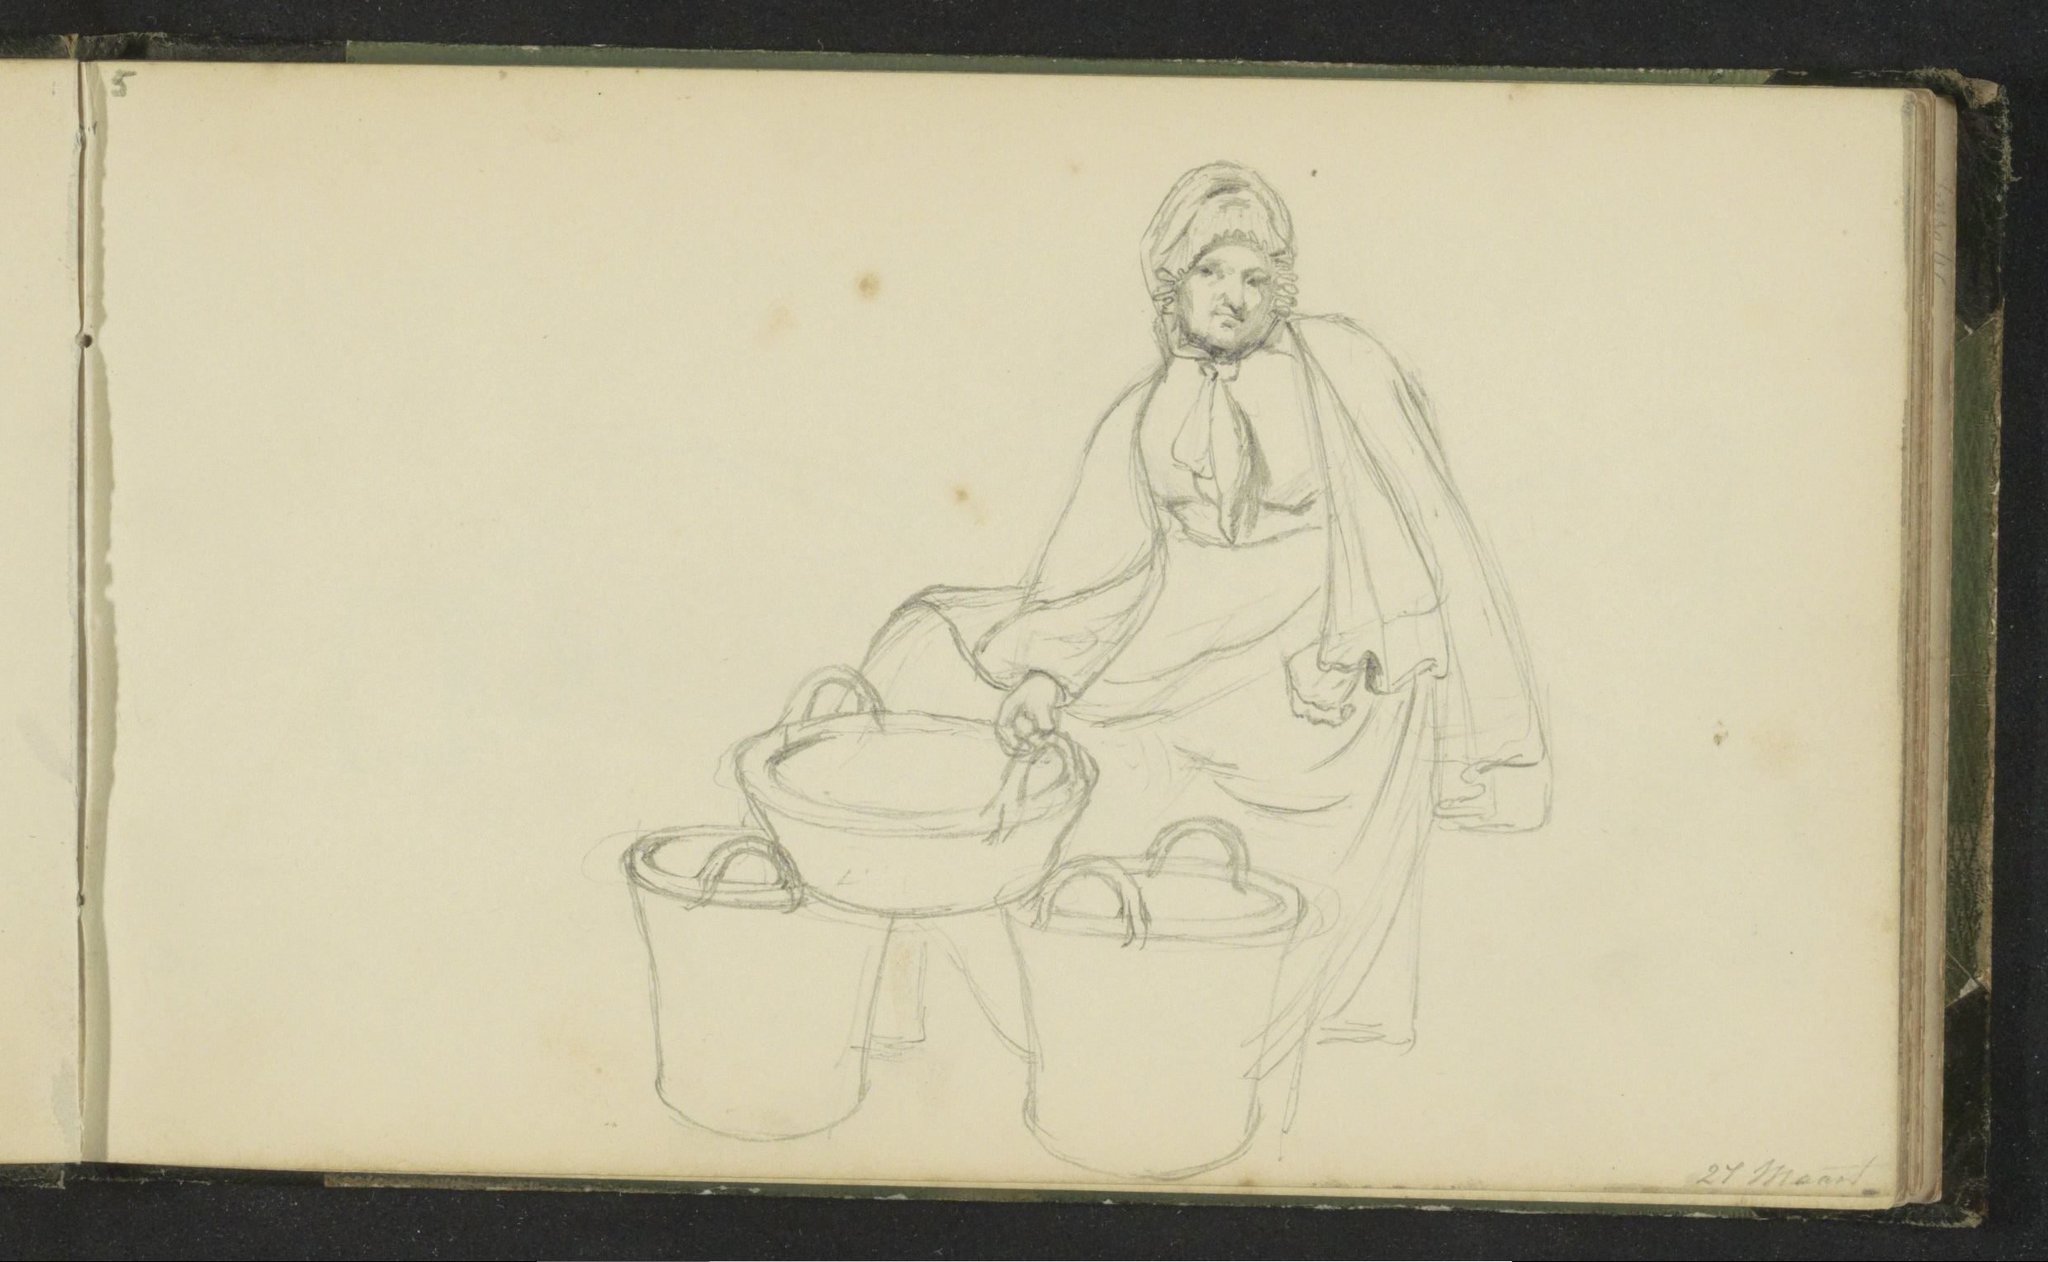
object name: sketchbook leaf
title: Zittende vrouw met drie manden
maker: hendrik abraham klinkhamer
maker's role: draughtsman, painter, print maker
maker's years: 1810-1872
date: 1803-1843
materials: paper, pencil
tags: sitting figure (+ old female (human being)), container made of plant material other than wood: basket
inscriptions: date: ‘27 Maart’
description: Blad 5 recto uit een schetsboek met 40 bladen.